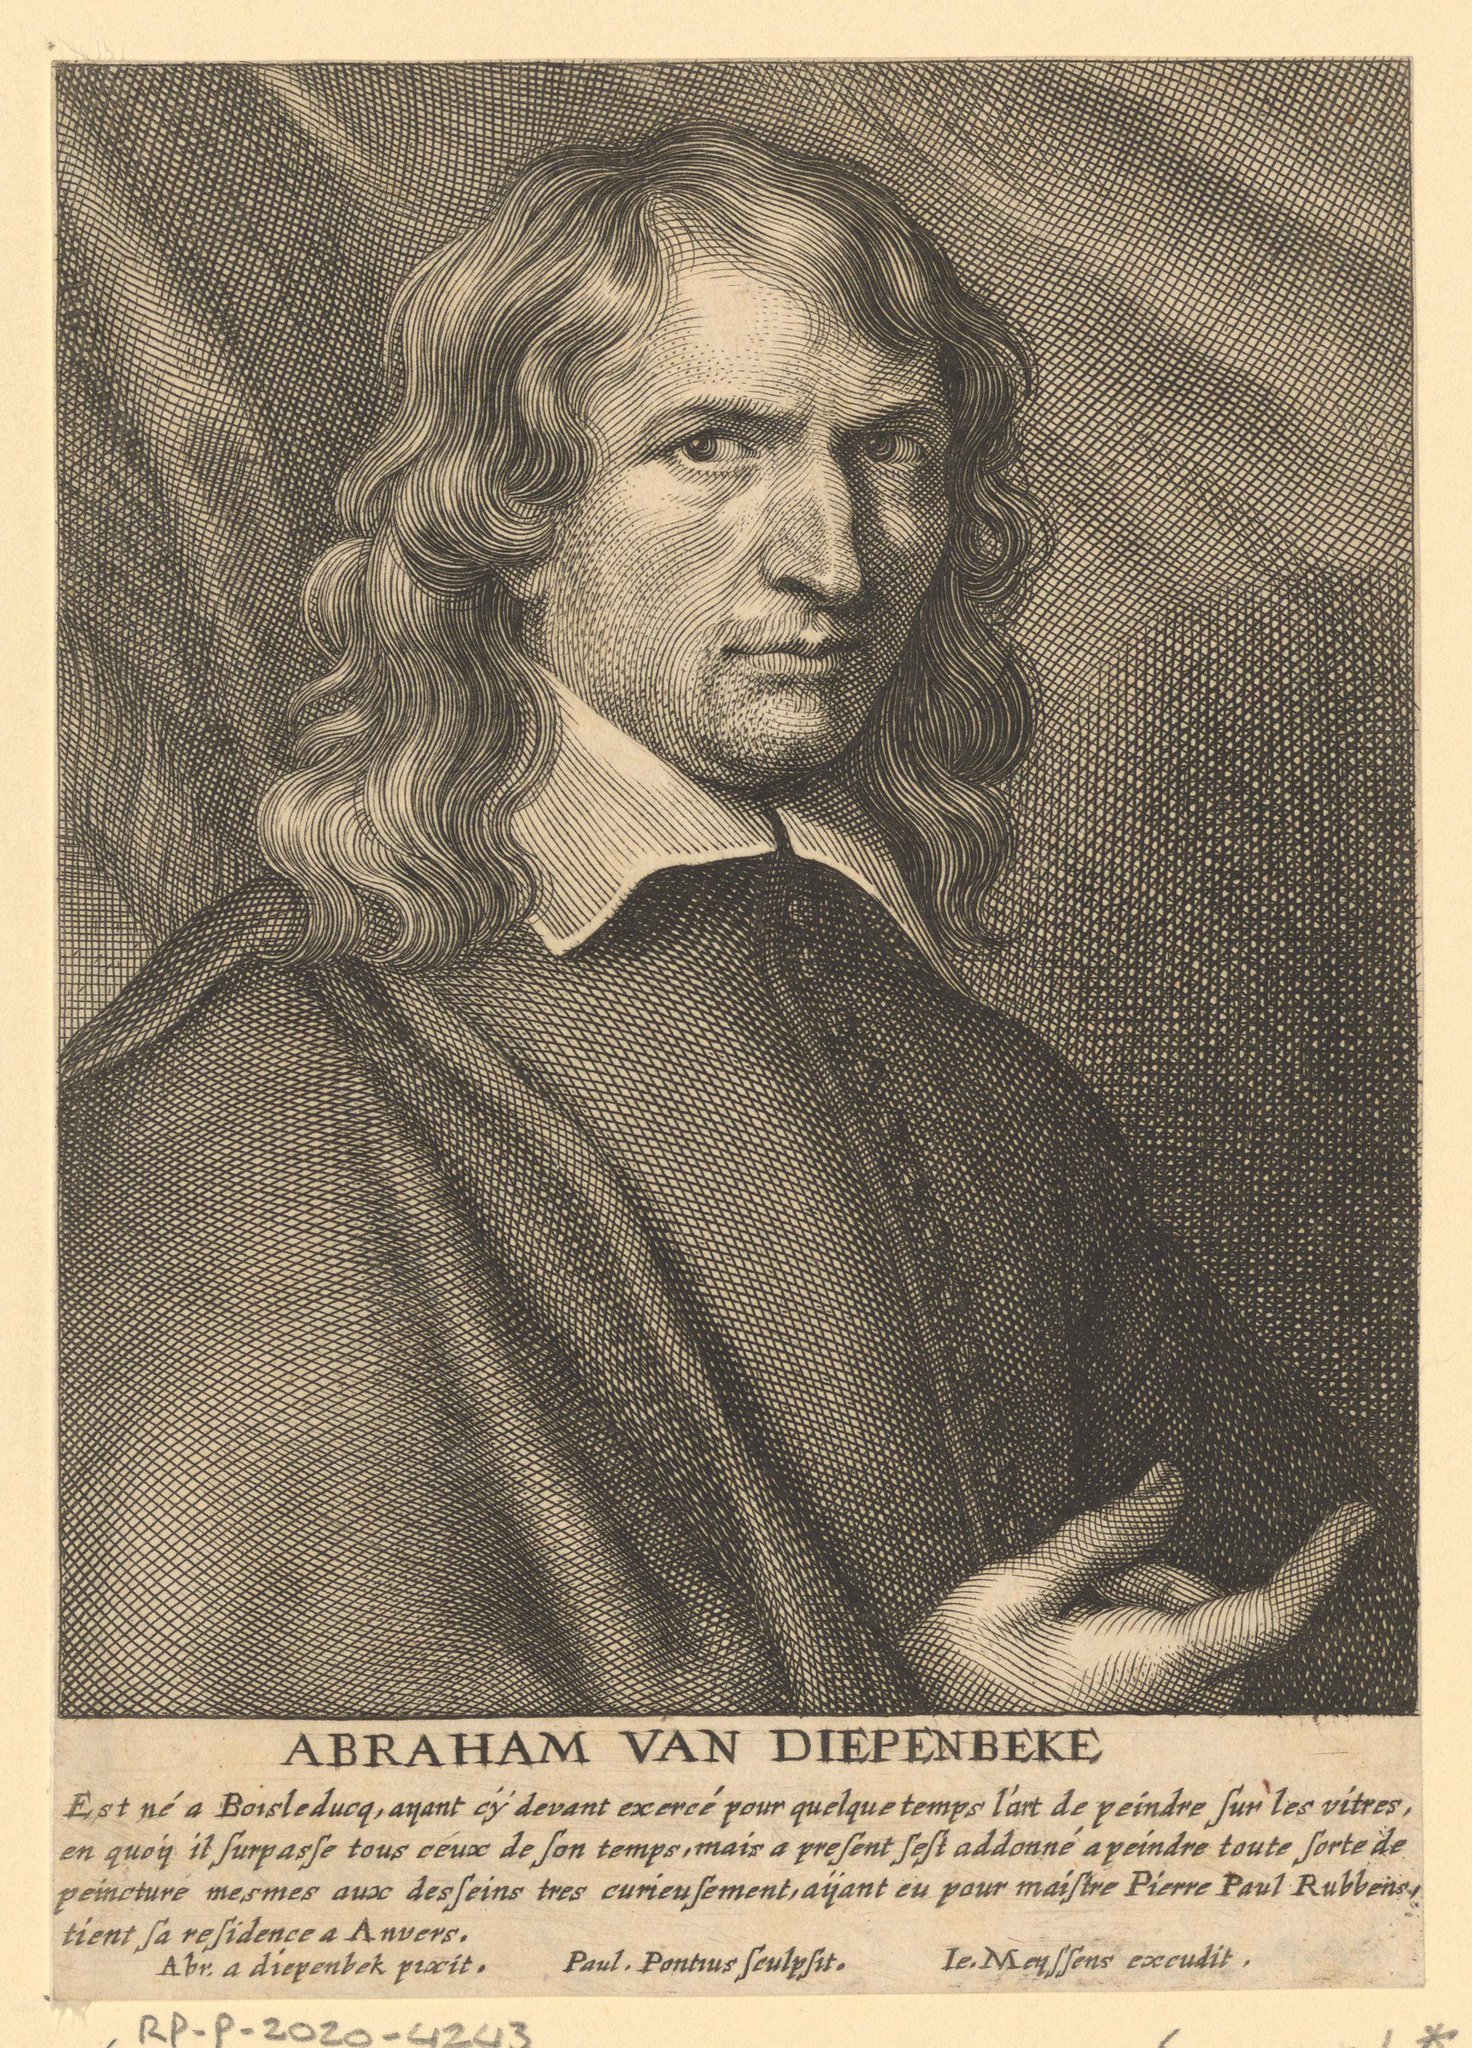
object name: print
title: Portret van Abraham van Diepenbeeck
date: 1622-1658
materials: paper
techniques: engraving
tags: den bosch, print maker, draughtsman, abraham van diepenbeeck, historical persons, portrait, self-portrait of painter